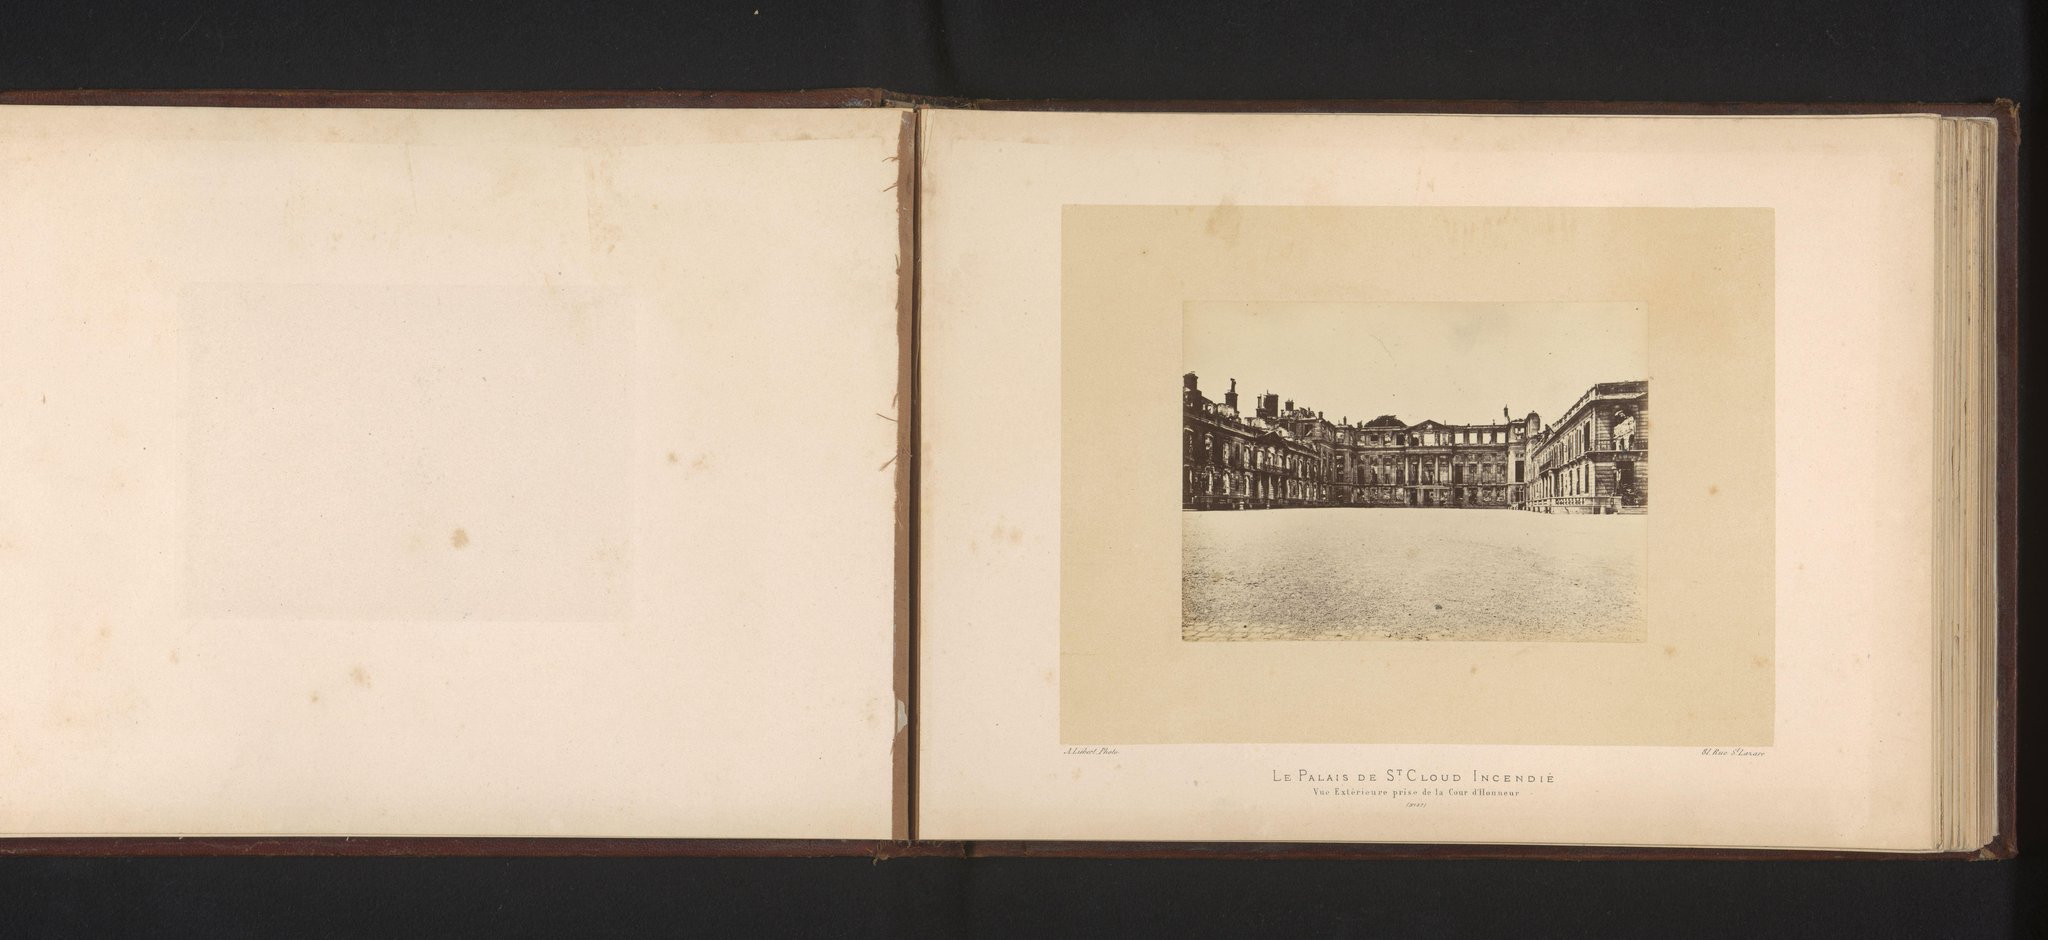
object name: page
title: Le Palais de St. Cloud Incendié. Vue Extérieure prise de la Cour d'Honneur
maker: alphonse-justin liébert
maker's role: fotograaf, marinier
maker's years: 1827-1914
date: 1871-1872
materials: photographic support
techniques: albumen print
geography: saint-cloud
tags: castle, ruin of a building ~ architecture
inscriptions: address: ‘31, Rue St. Lazare’, number: ‘(No. 57)’